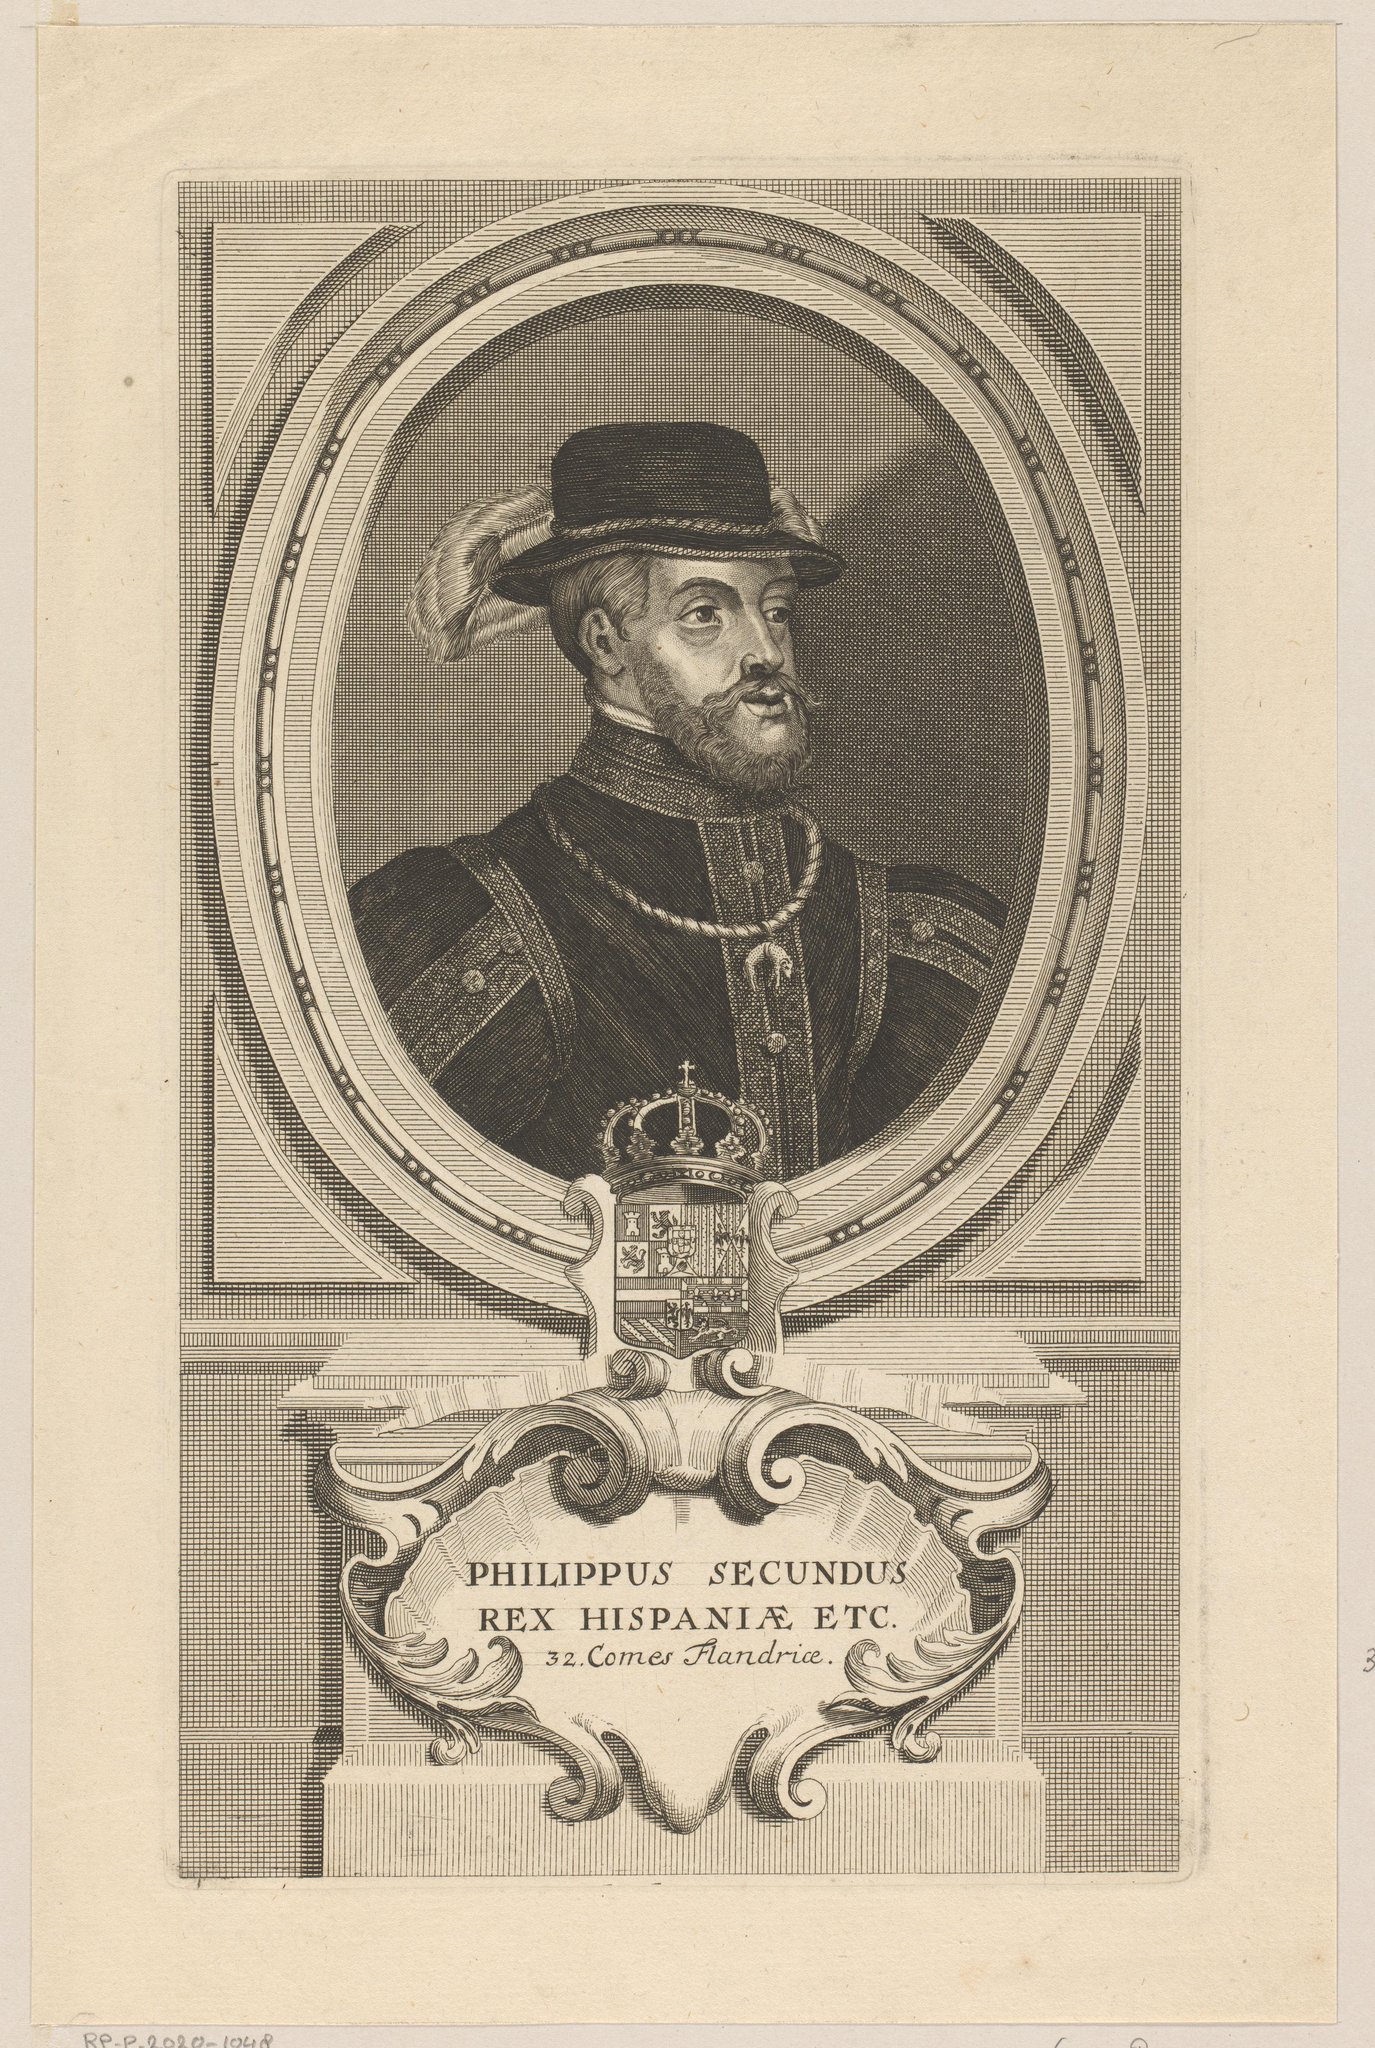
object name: print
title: Philippus secundus rex Hispaniae etc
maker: Anonymous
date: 1735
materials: paper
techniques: engraving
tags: philip ii of spain, historical persons, king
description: Prent ook gebruikt in: Sanderus, Antonius. Flandria illustrata sive provinciae ac comitatus (...). 3 dln. Brussel: Carolus en Joannes Baptista de Vos, 1735, dl. 1.